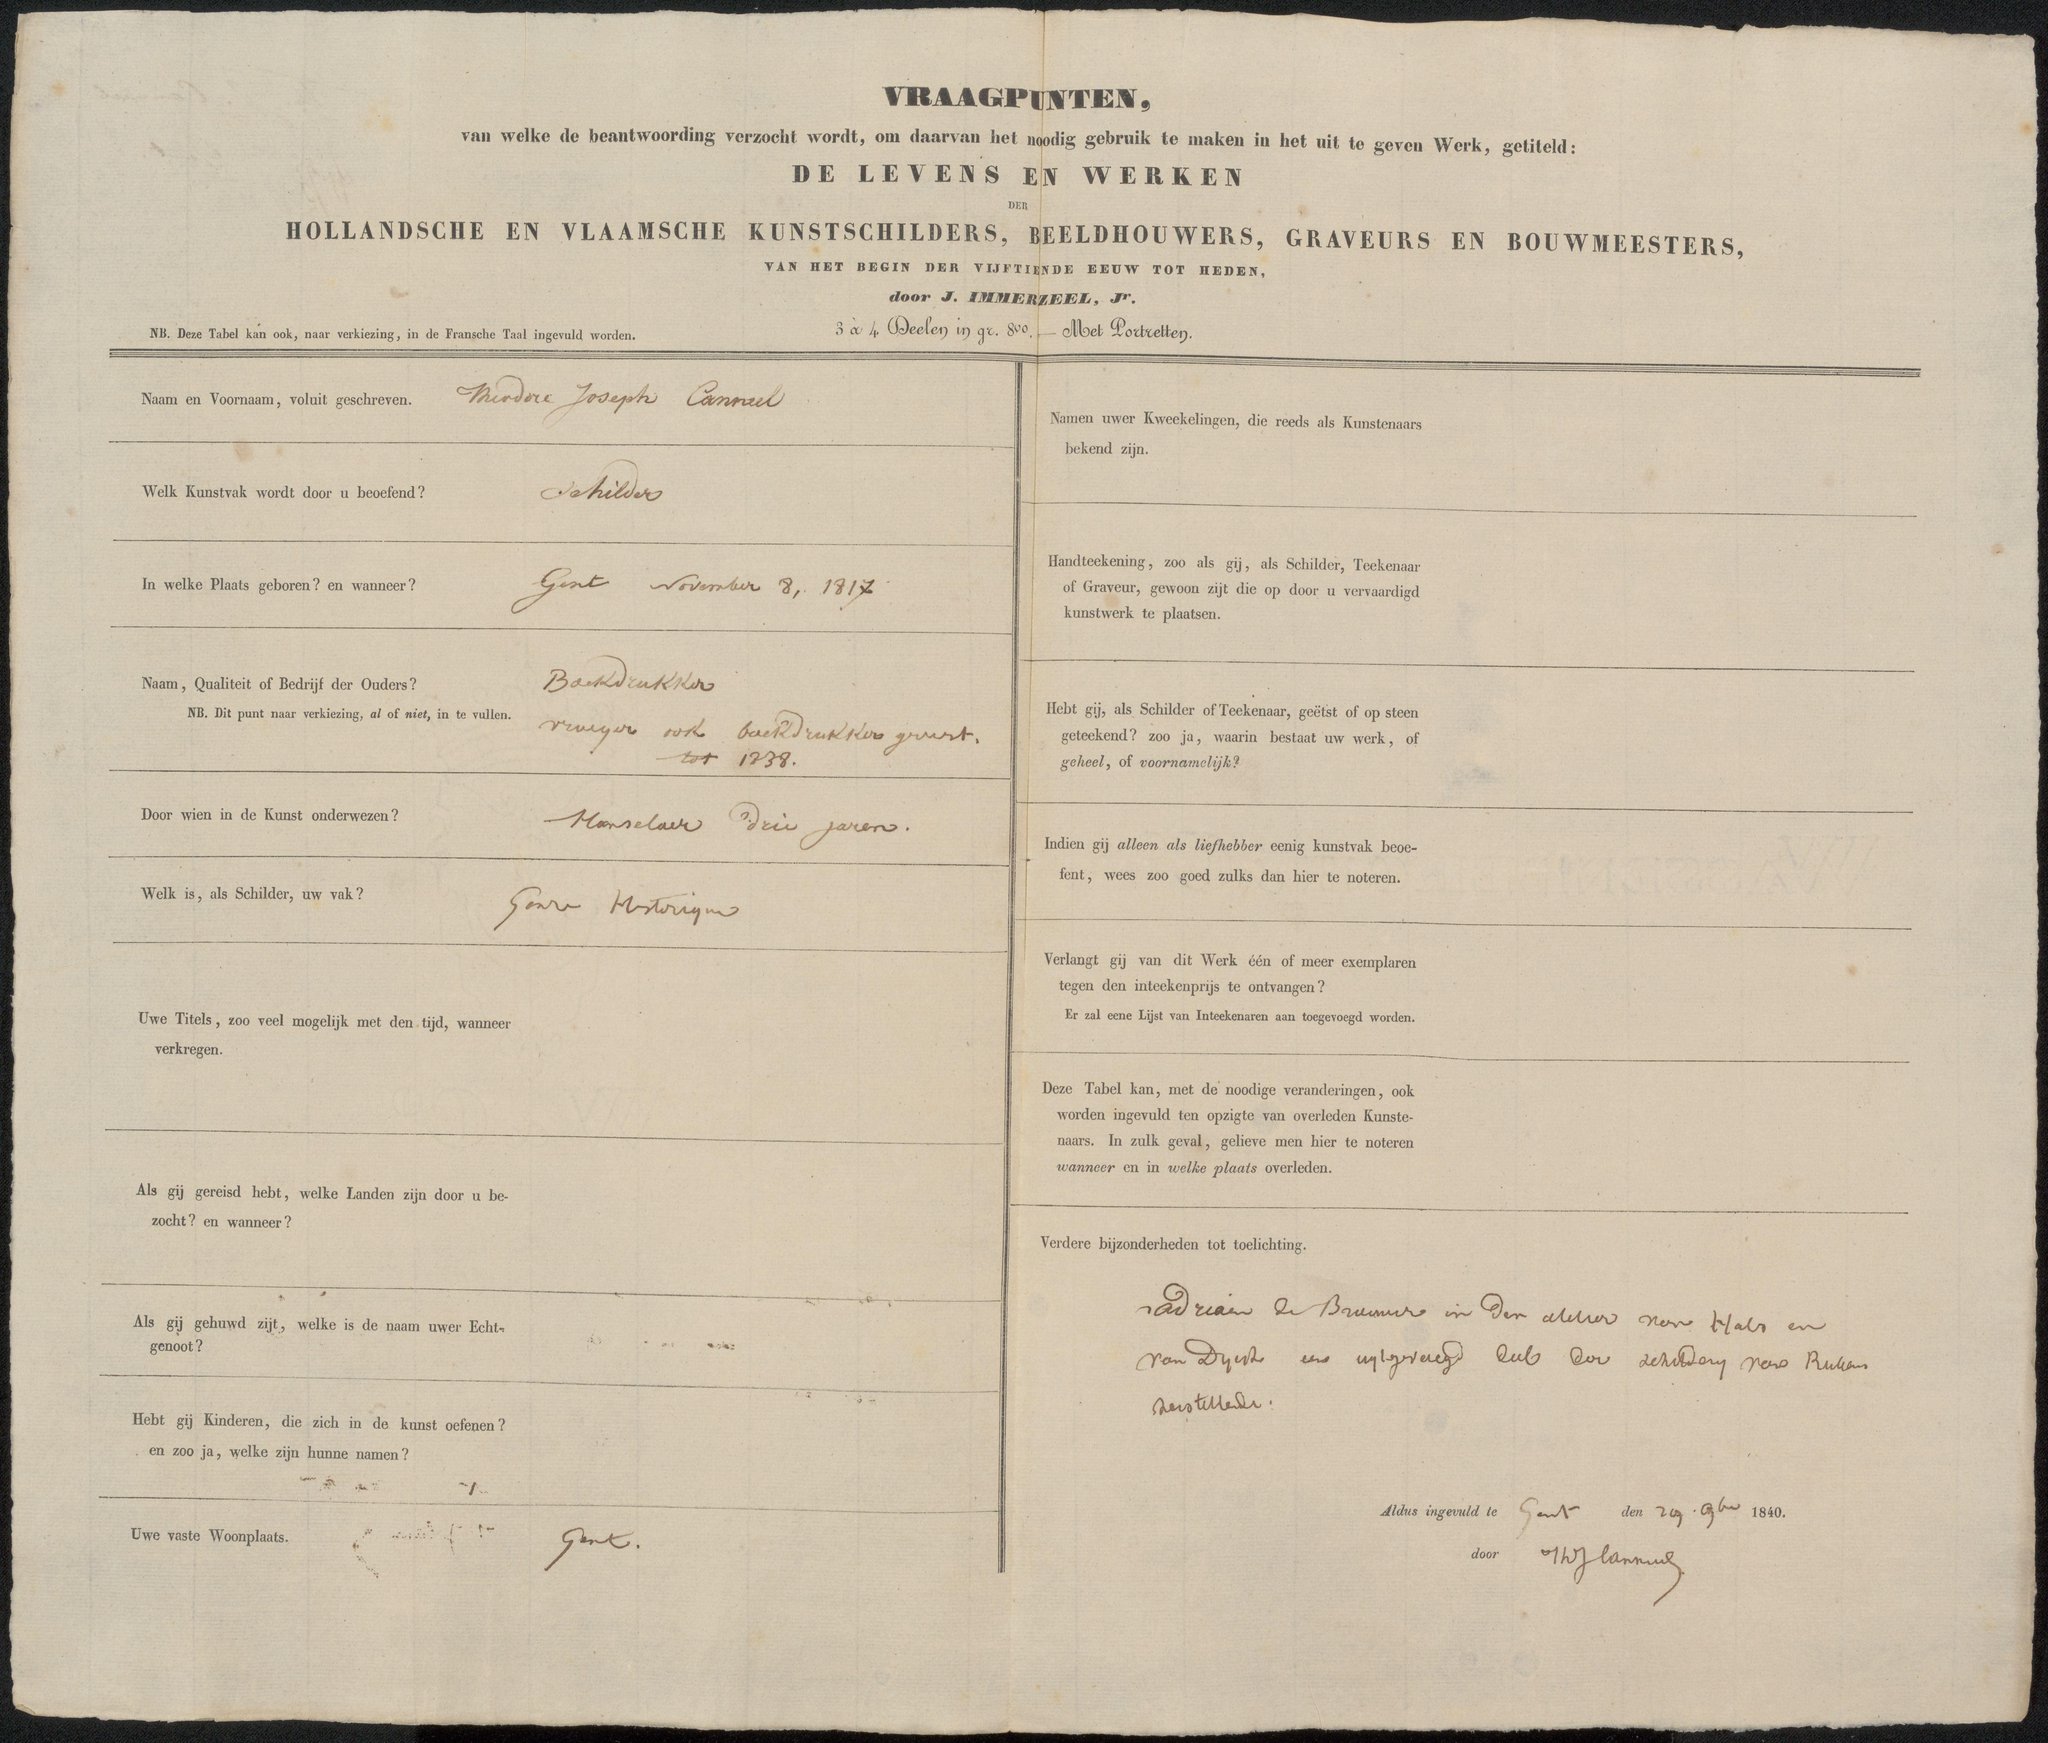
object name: manuscript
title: Enquêteformulier ingevuld door Théodore Joseph Canneel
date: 1840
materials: ink, paper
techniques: pen, printing, writing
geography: ghent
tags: ghent, painter, théodore joseph canneel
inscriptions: watermark, inscription: ‘Vraagpunten,/ van welke de beantwoording verzocht wordt, om daarvan het noodig gebruik te maken in het uit te geven Werk, getiteld: De levens en werken/ der Hollandsche en Vlaamsche kunstschilders, beeldhouwers,/ graveurs en bouwmeesters, van het begin der vijftiende eeuw tot heden/ door J. Immerzeel, Jr.’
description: Opgenomen in: Immerzeel, J. Jr., De levens en werken der Hollandsche en Vlaamsche kunstschilders, beeldhouwers, graveurs en bouwmeesters, van het begin der vijftiende eeuw tot heden, Amsterdam: J.C. van Kesteren, 1842-1843.